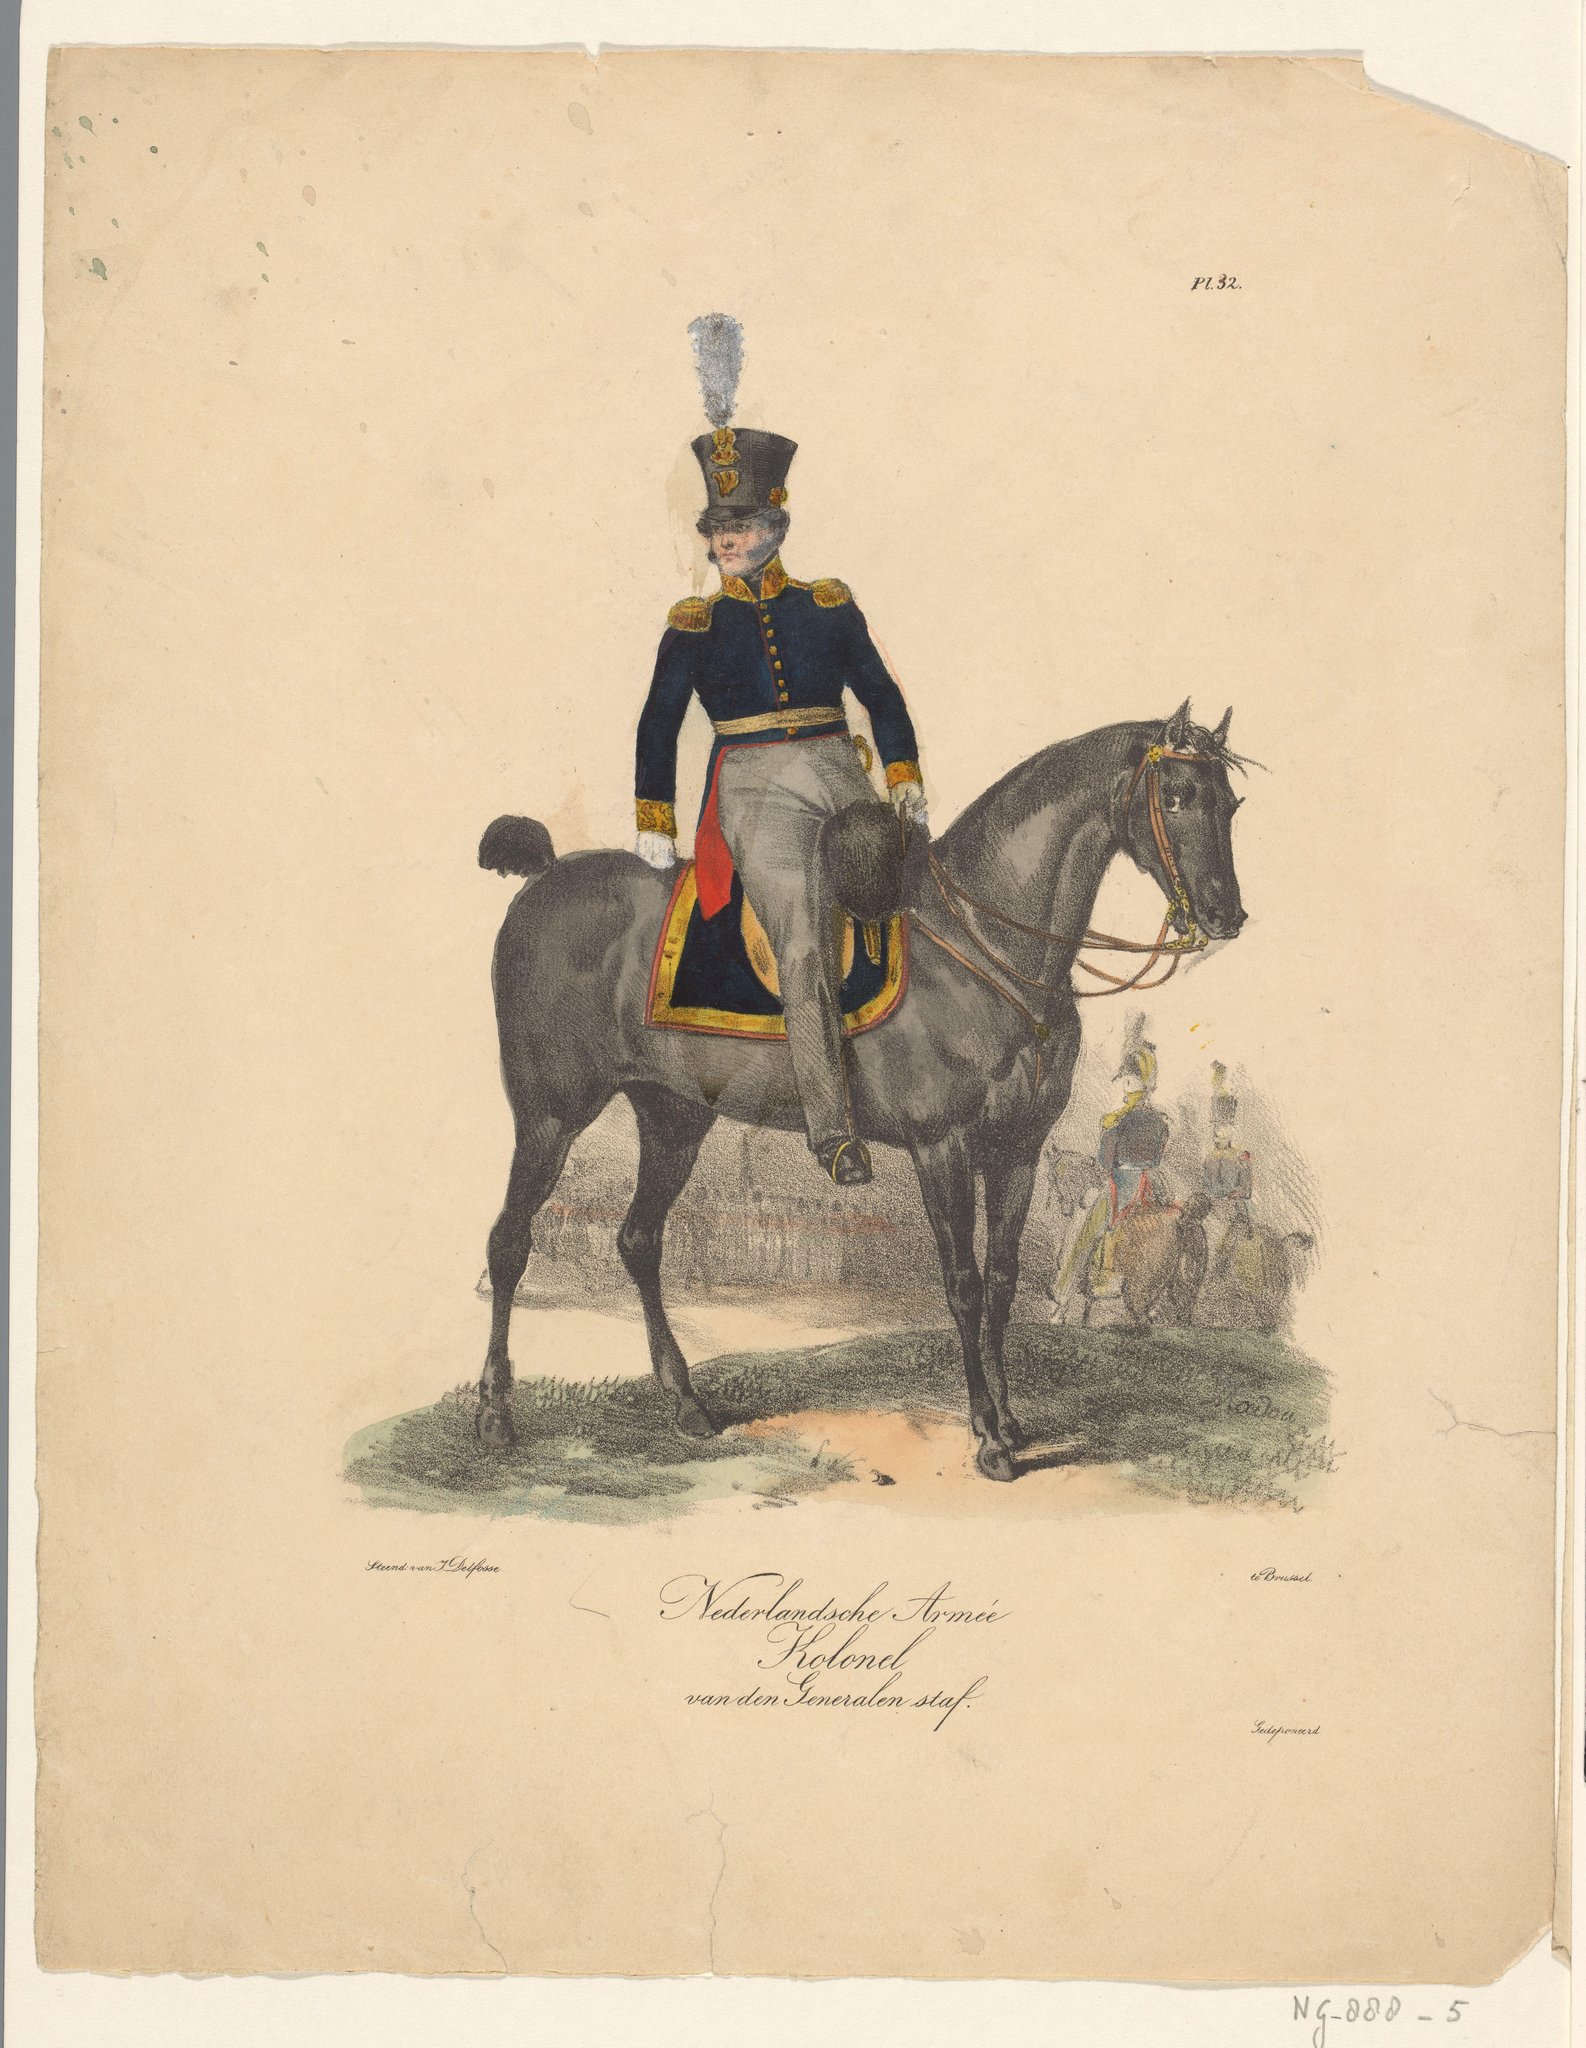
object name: print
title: Nederlandsche Armée / Kolonel van den Generalen staf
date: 1823-1827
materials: paper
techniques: hand coloring, lithograph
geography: brussels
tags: (military) uniforms (+ cavalry, horsemen)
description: Een kolonel van de Generale Staf, te paard. Op de achtergrond een generaal voor zijn troepen. Genummerd rechtsboven: 52. Afkomstig uit een plaatwerk van uniformen van het Nederlandse leger, ca. 1825.